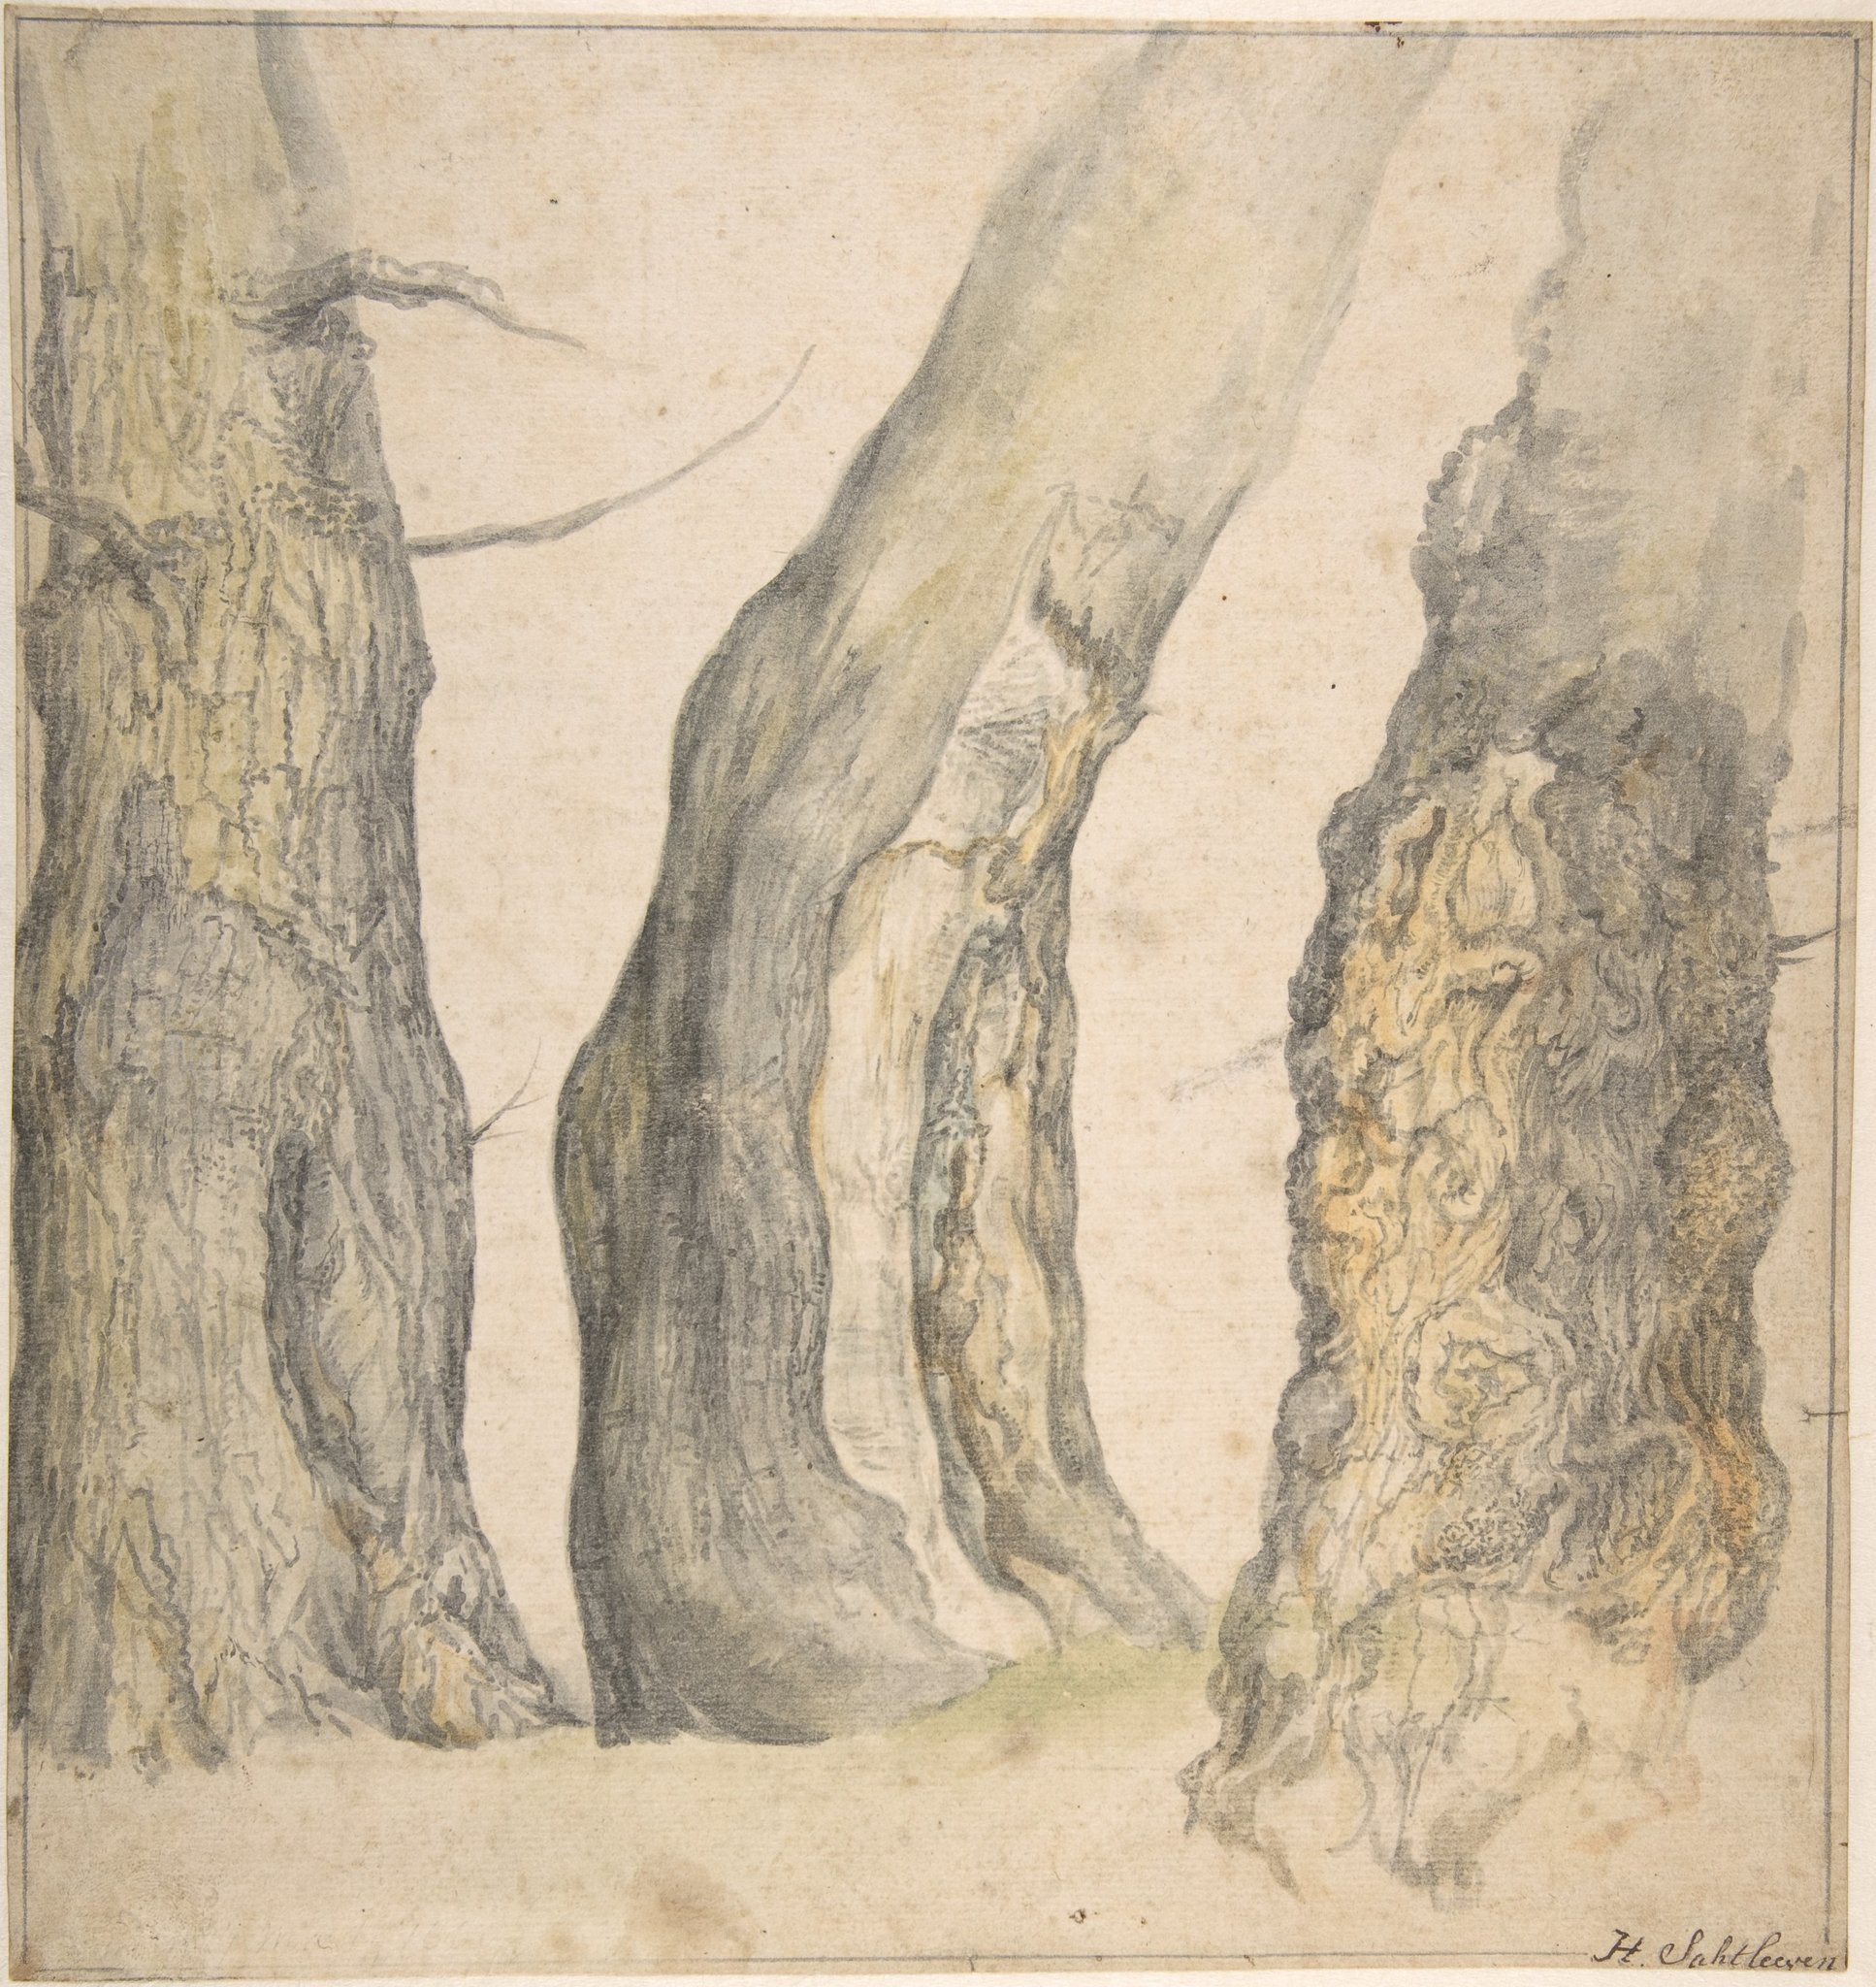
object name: drawing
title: Study of Three Old Gnarled Trees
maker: jan siberechts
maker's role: draughtsman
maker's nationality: flemish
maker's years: 1627-1703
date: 1660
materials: watercolor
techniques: brush, wash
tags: trees